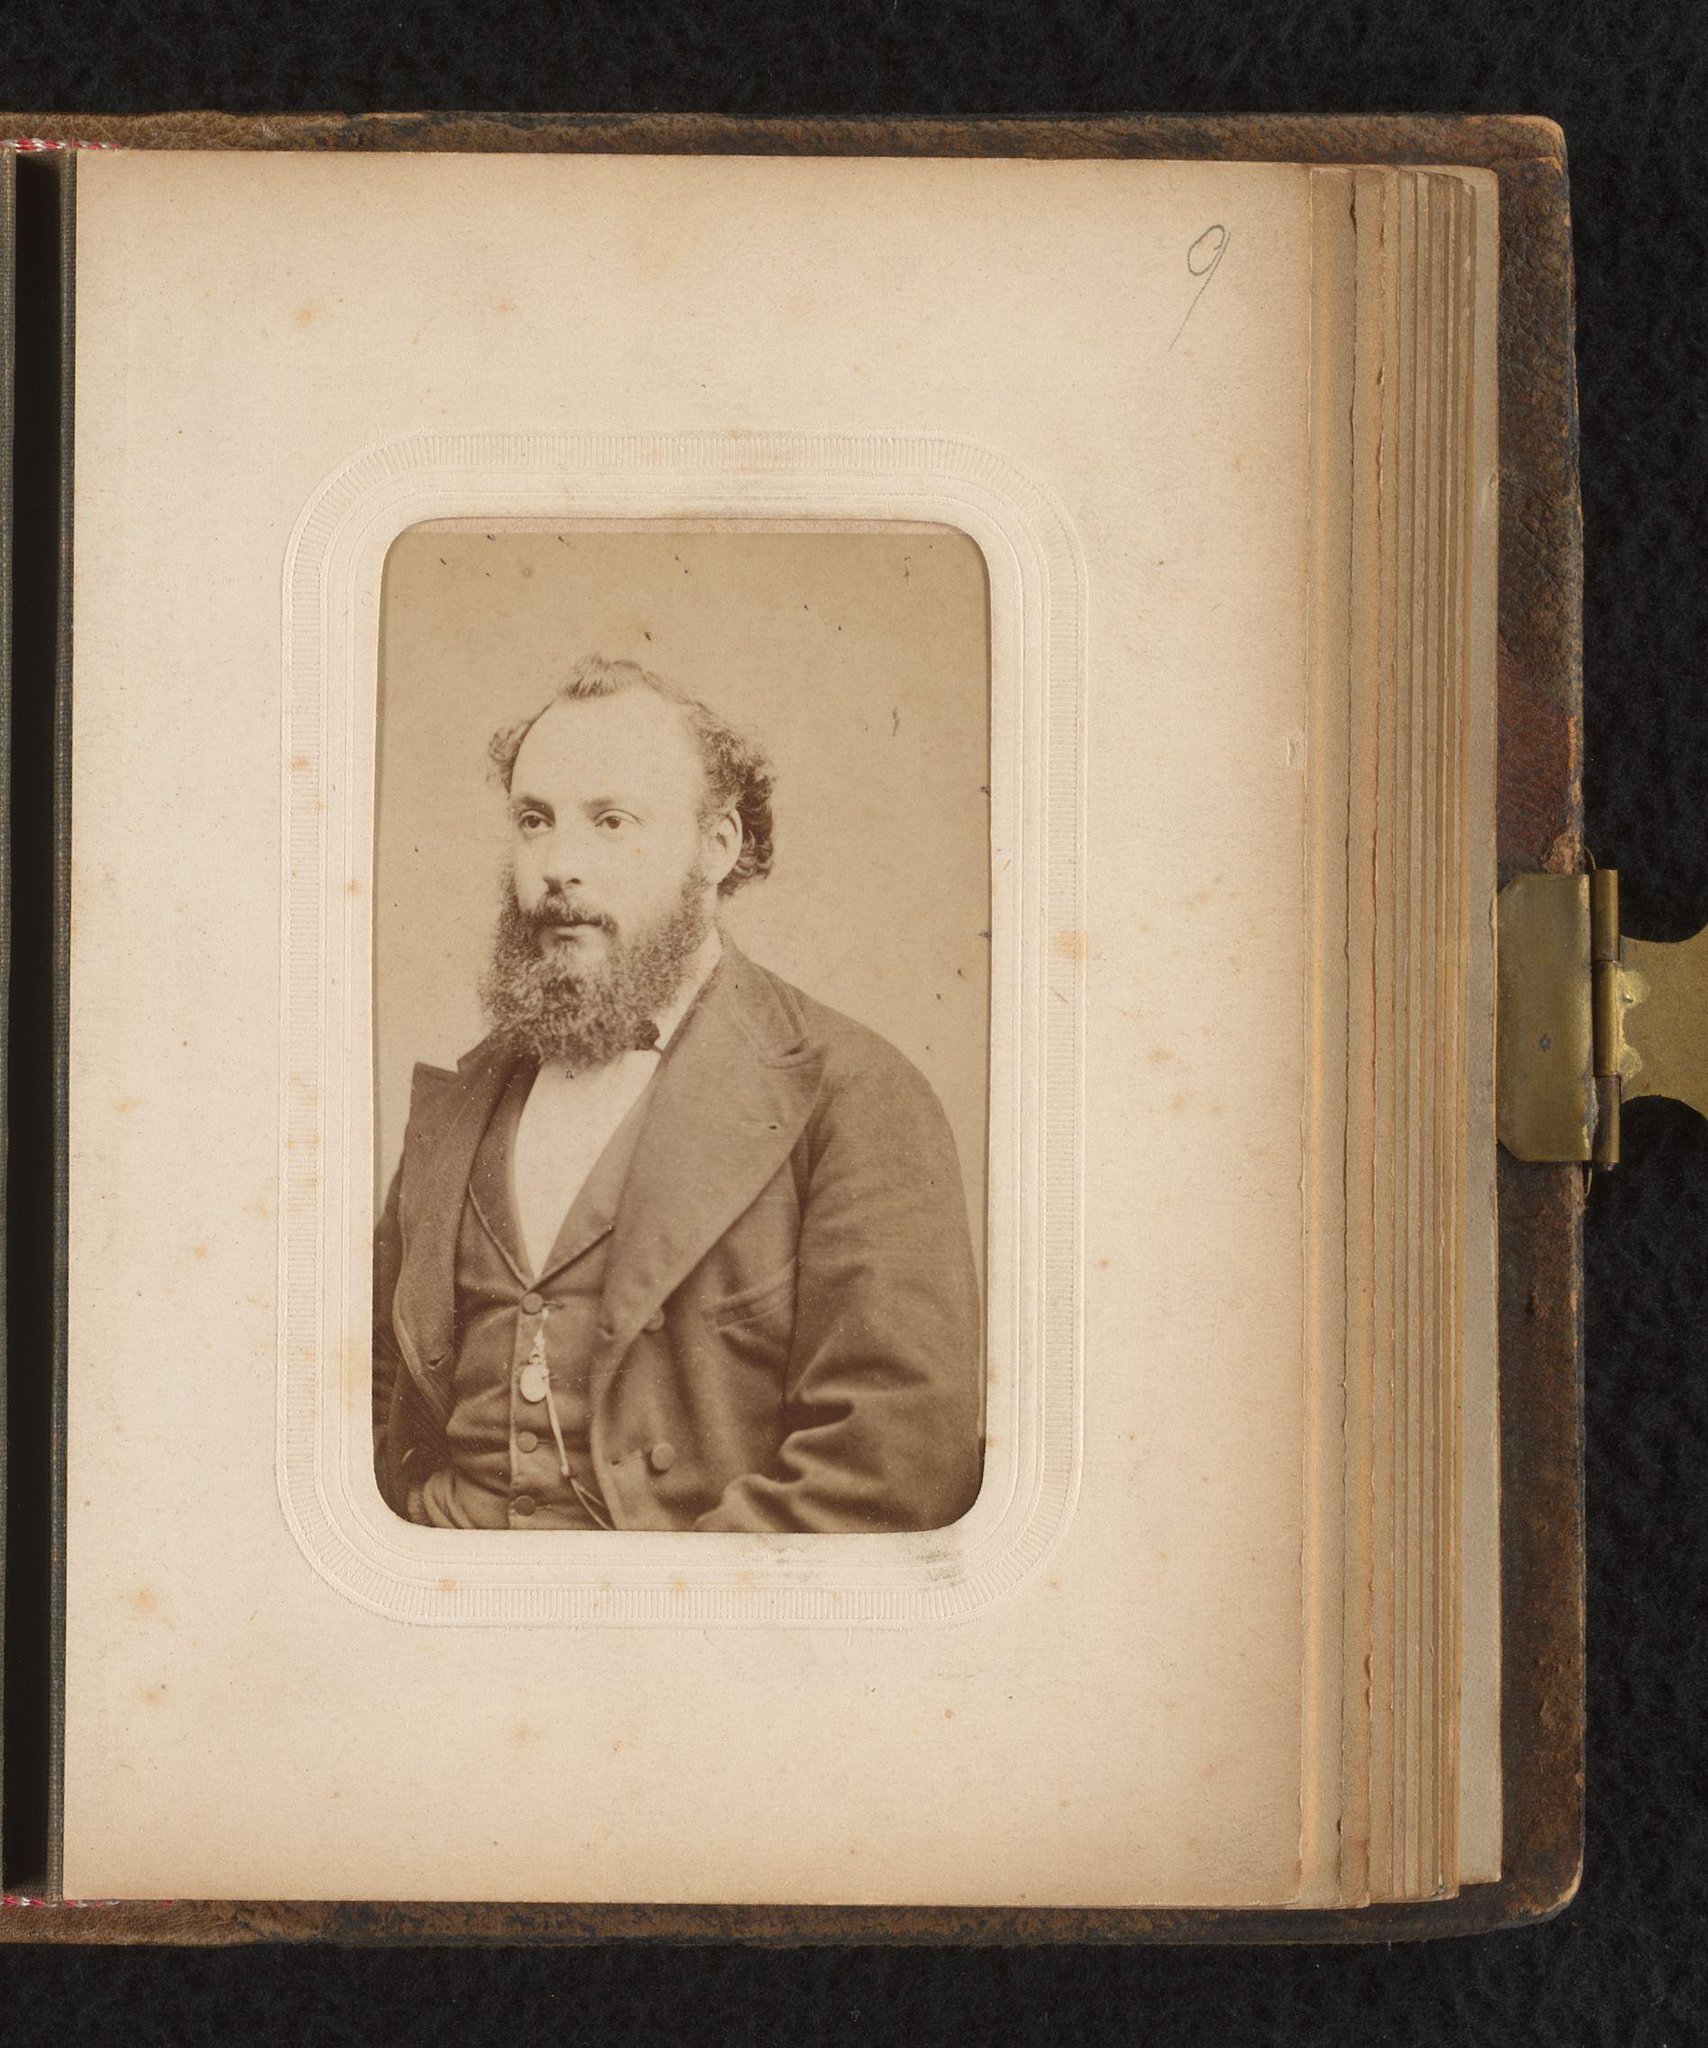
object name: carte de visite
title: Portret van Petrus Hermanus Bon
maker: louis robert werner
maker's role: fotograaf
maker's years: 1834-1896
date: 1866-1896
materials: cardboard, paper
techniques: albumen print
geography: amsterdam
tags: amsterdam, historical persons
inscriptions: inscription: ‘Petrus Hermanus/ Bon’, inscription: ‘L.R. Werner/ voorheen/ P. Carstensen/ Nieuwendyk H.150/ Amsterdam’